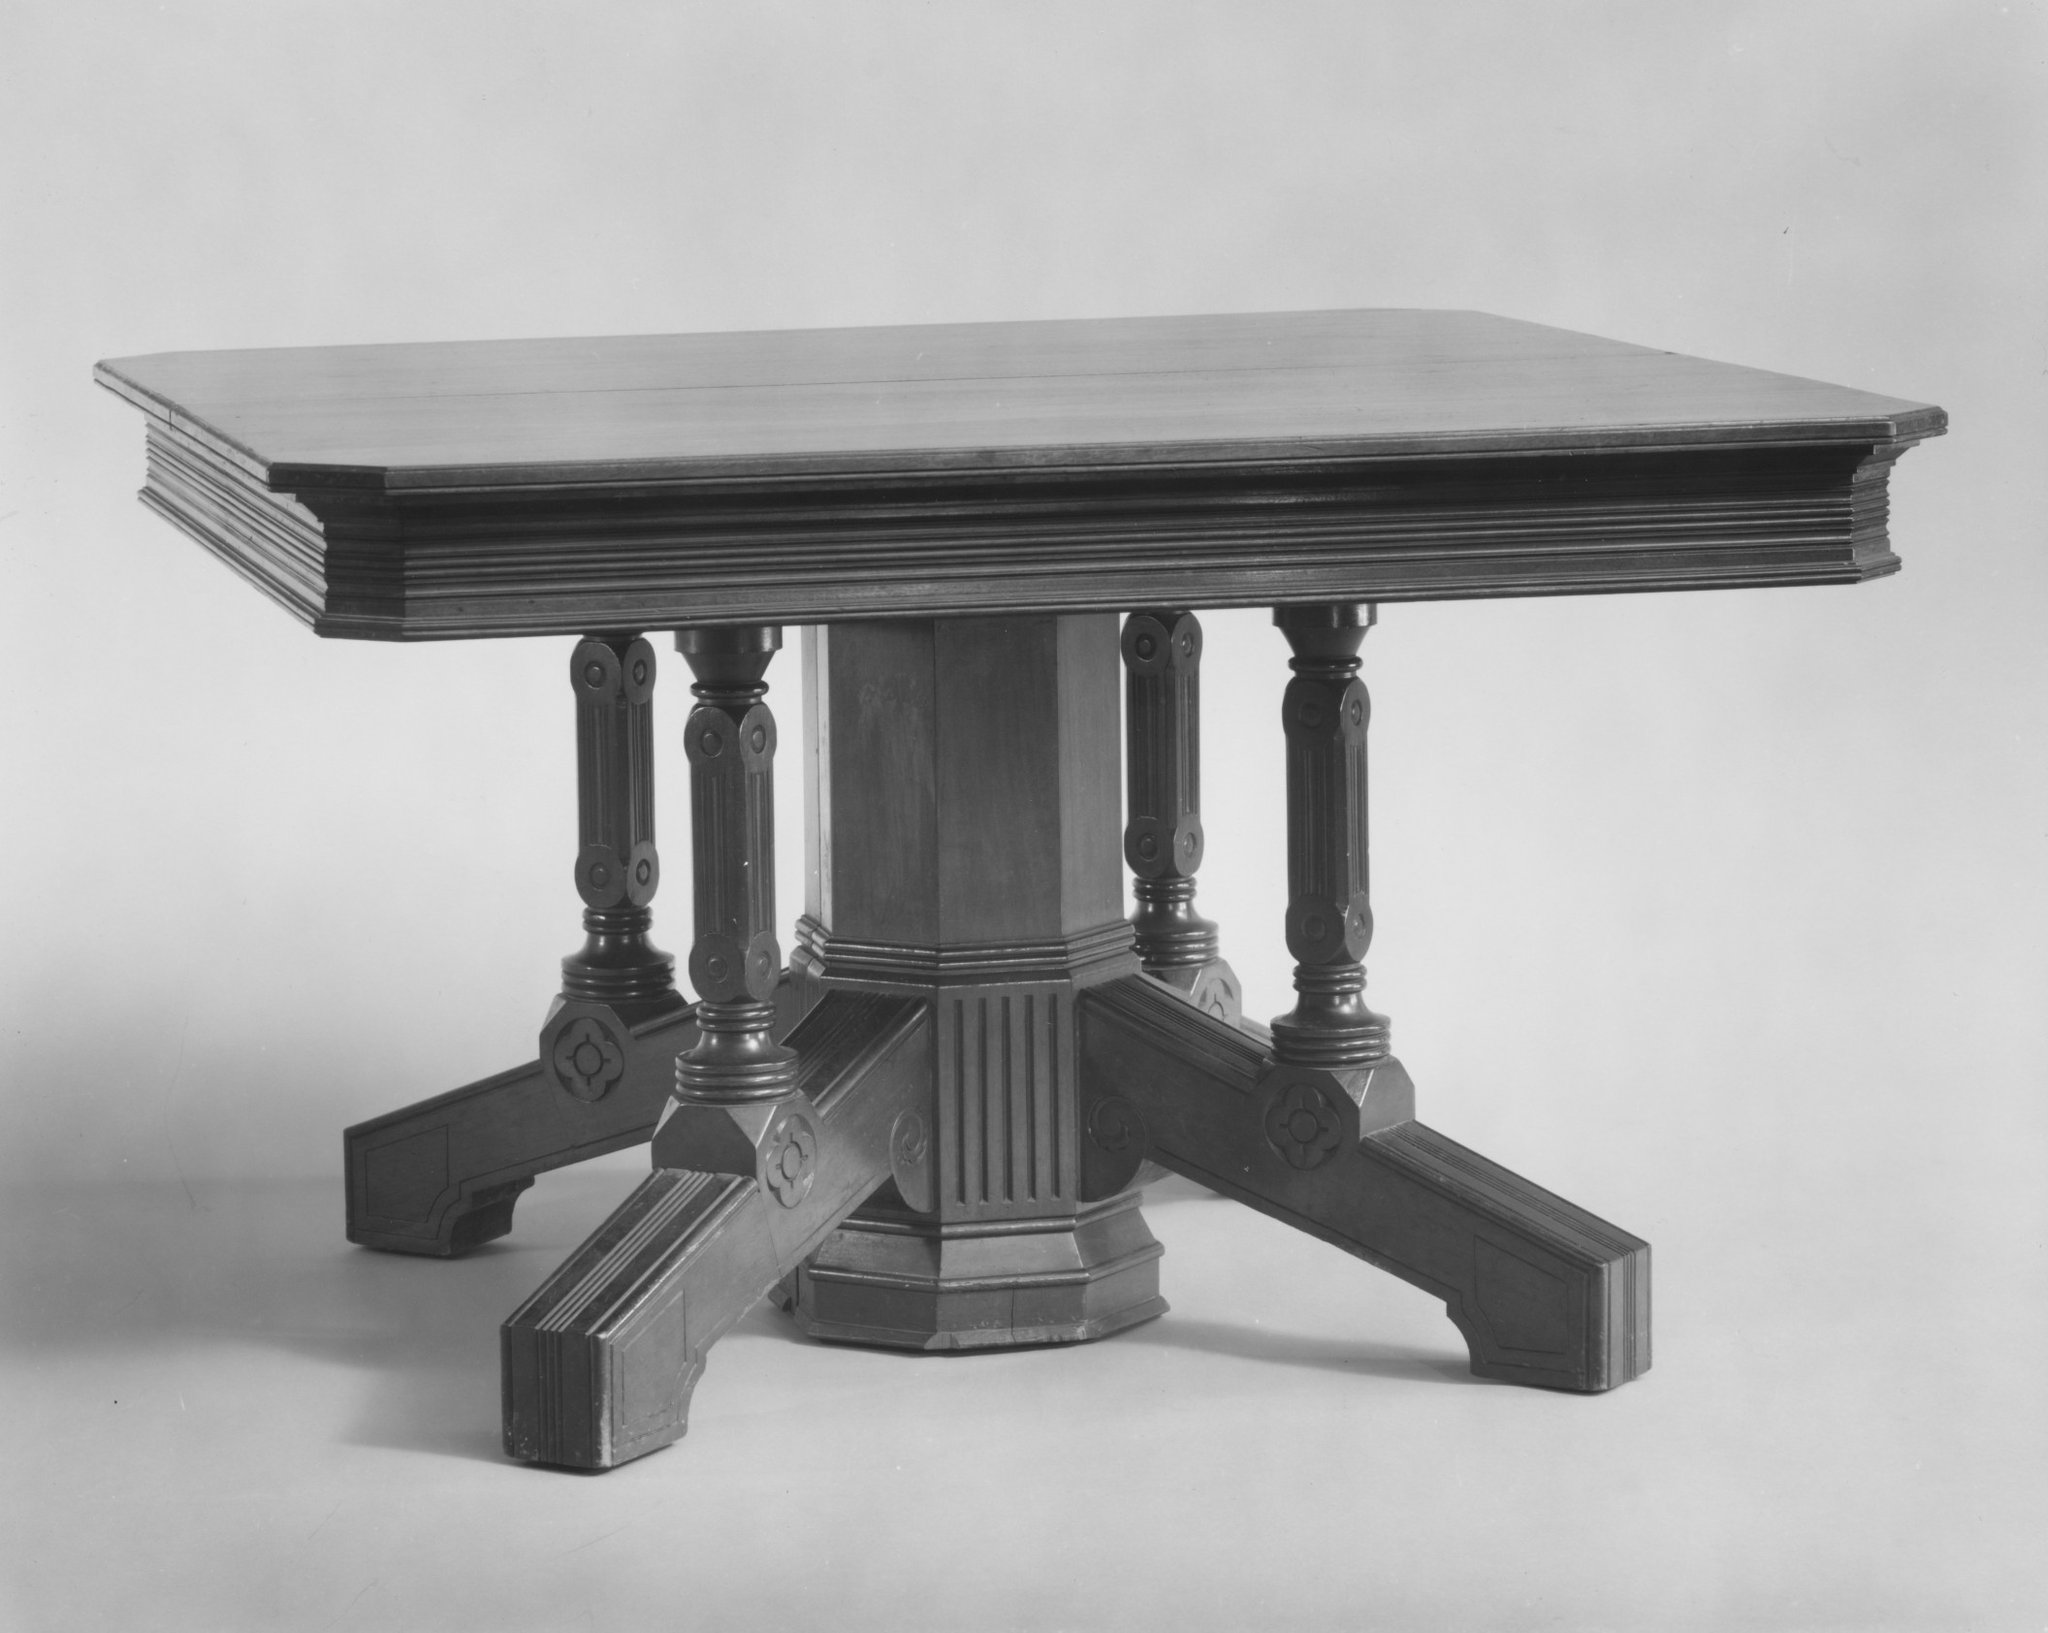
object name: extension table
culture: american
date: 1877-1880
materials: wood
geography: united states